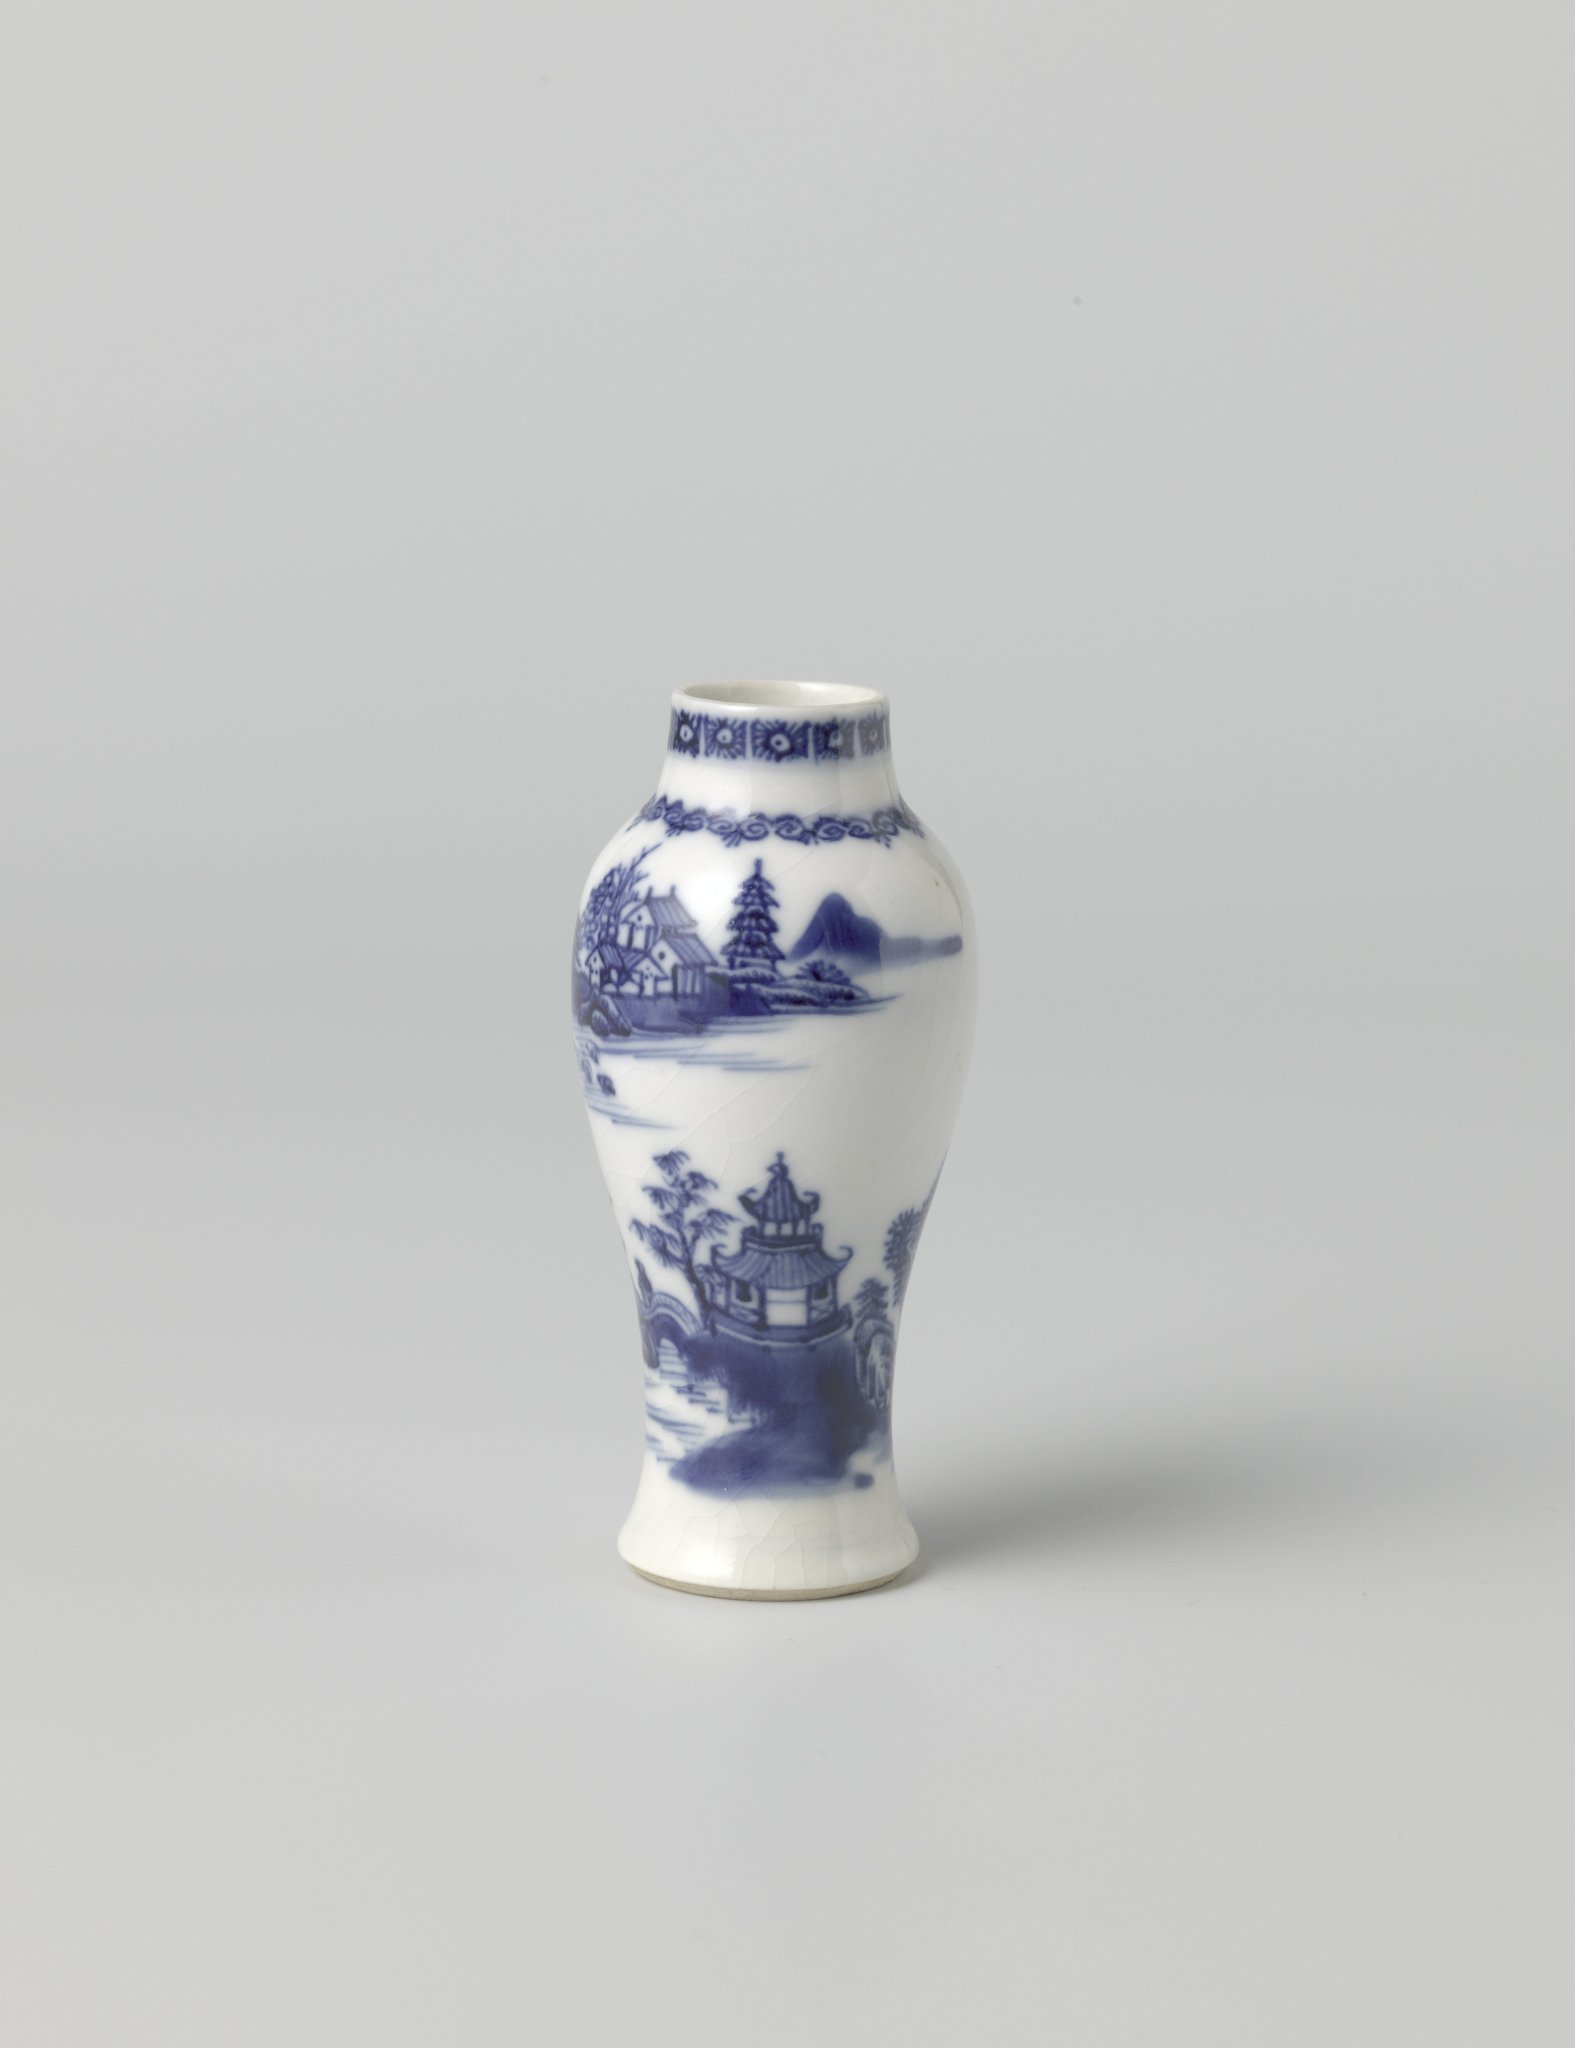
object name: dekselvaas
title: Baluster jar with river landscape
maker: Anonymous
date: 1800-1899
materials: cobalt, glaze, paint, porcelain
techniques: firing, turning, vitrification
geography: china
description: Balustervormige pot (deksel ontbreekt) van porselein, beschilderd in onderglazuur blauw. Op de wand een rivierlandschap met personen, rotsen, bomen, paviljoens en een boot; op de schouder een band met krulwerk, om de nek een decoratieve band. Gecraqueleerd glazuur. Blauw-wit.